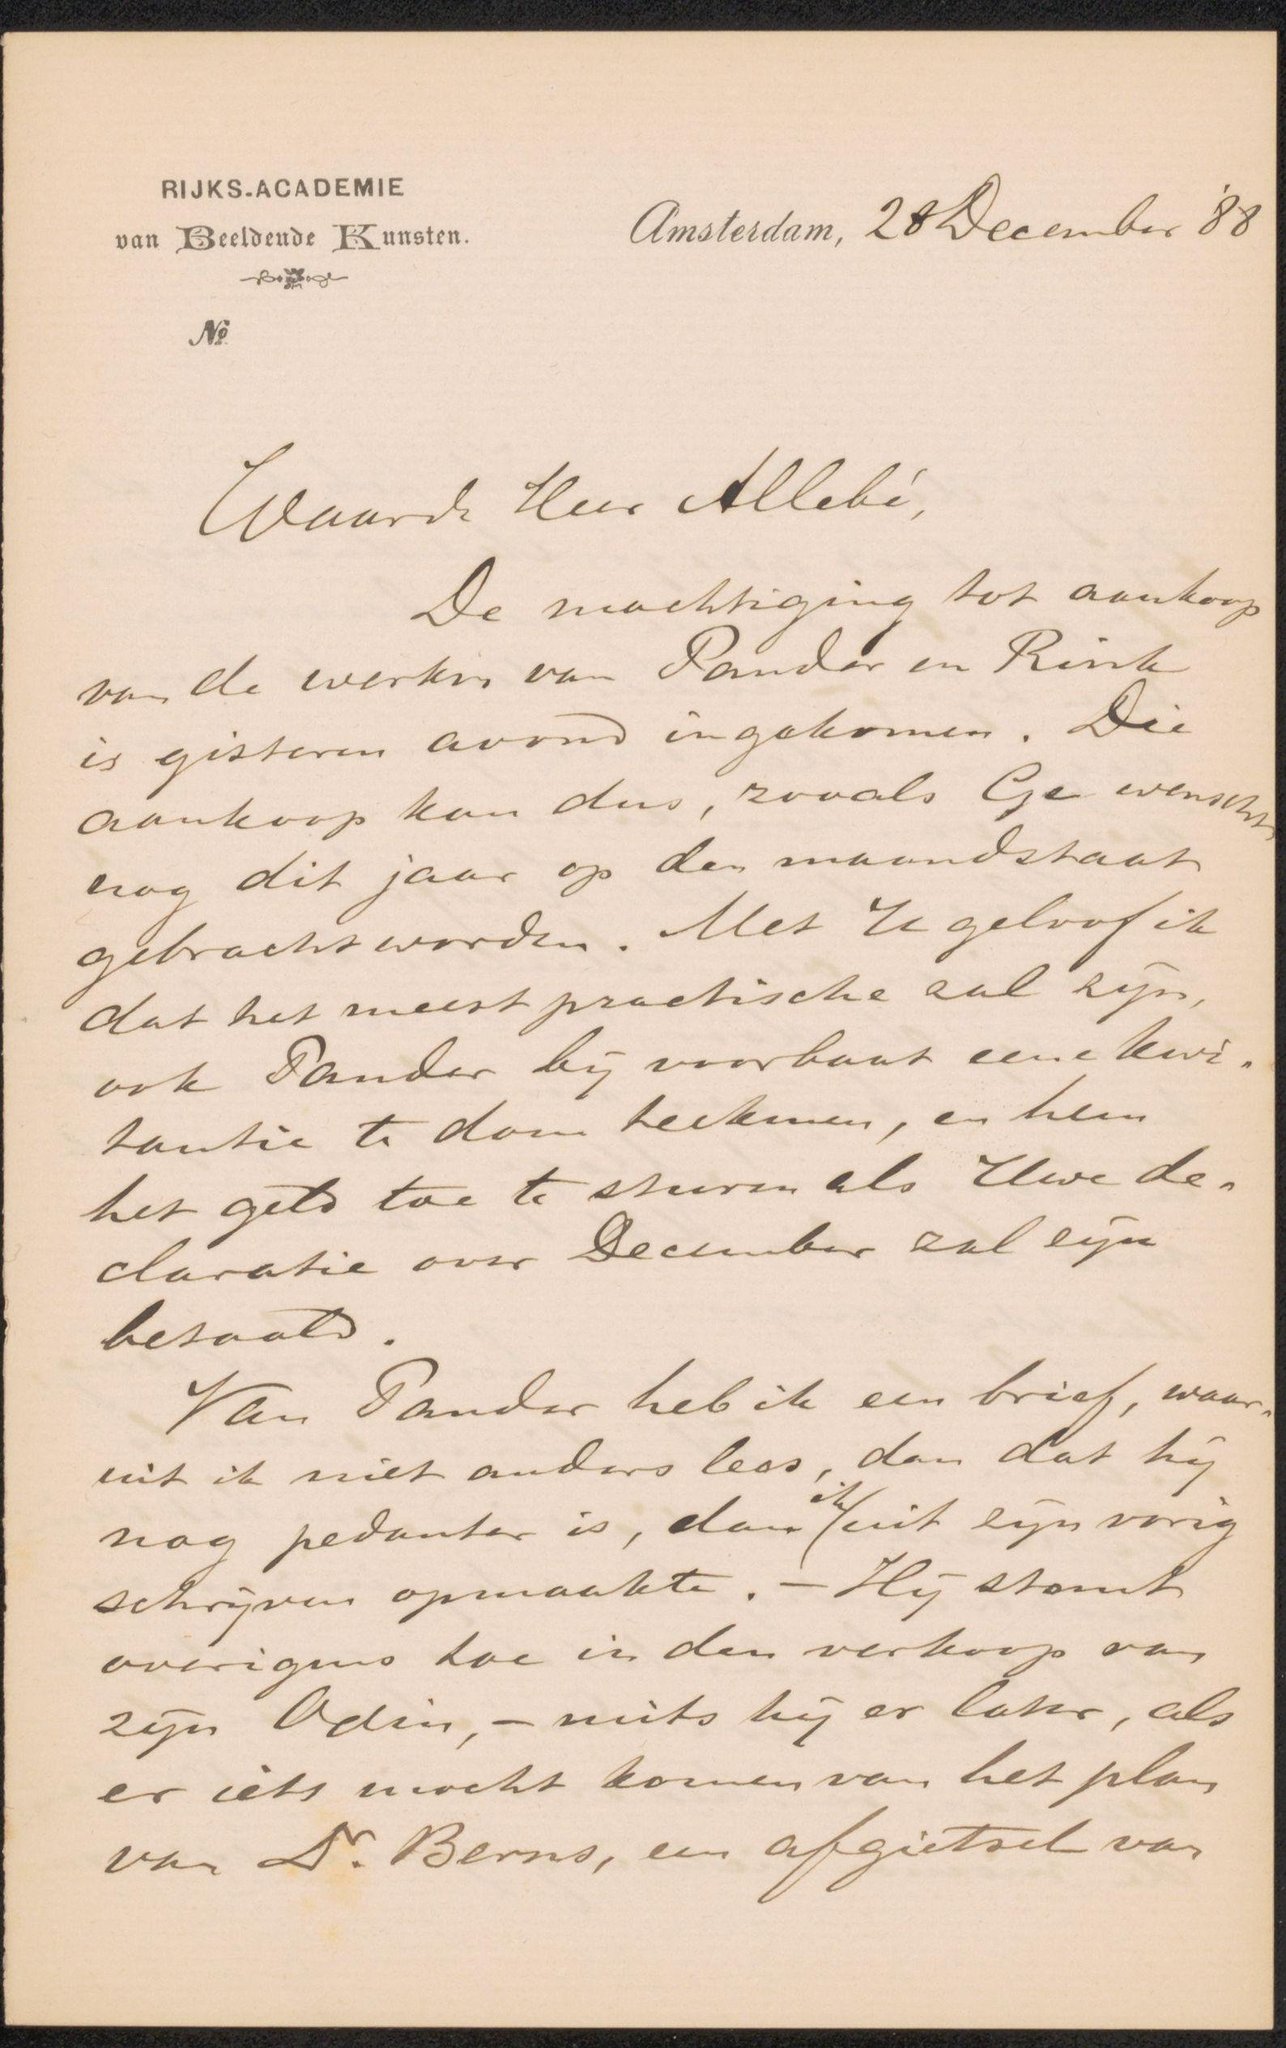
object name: letter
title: Brief aan August Allebé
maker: jérôme alexander sillem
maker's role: politician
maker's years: 1840-1912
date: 1888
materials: ink, paper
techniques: pen, printing, writing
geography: amsterdam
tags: utrecht, anthonius wilhelm cornelis berns, amsterdam, august allebé, print maker, draughtsman, paul rink, rome, designer, sculptor, pier pander, art trade, art shop, sculpture, art collecting, money, london